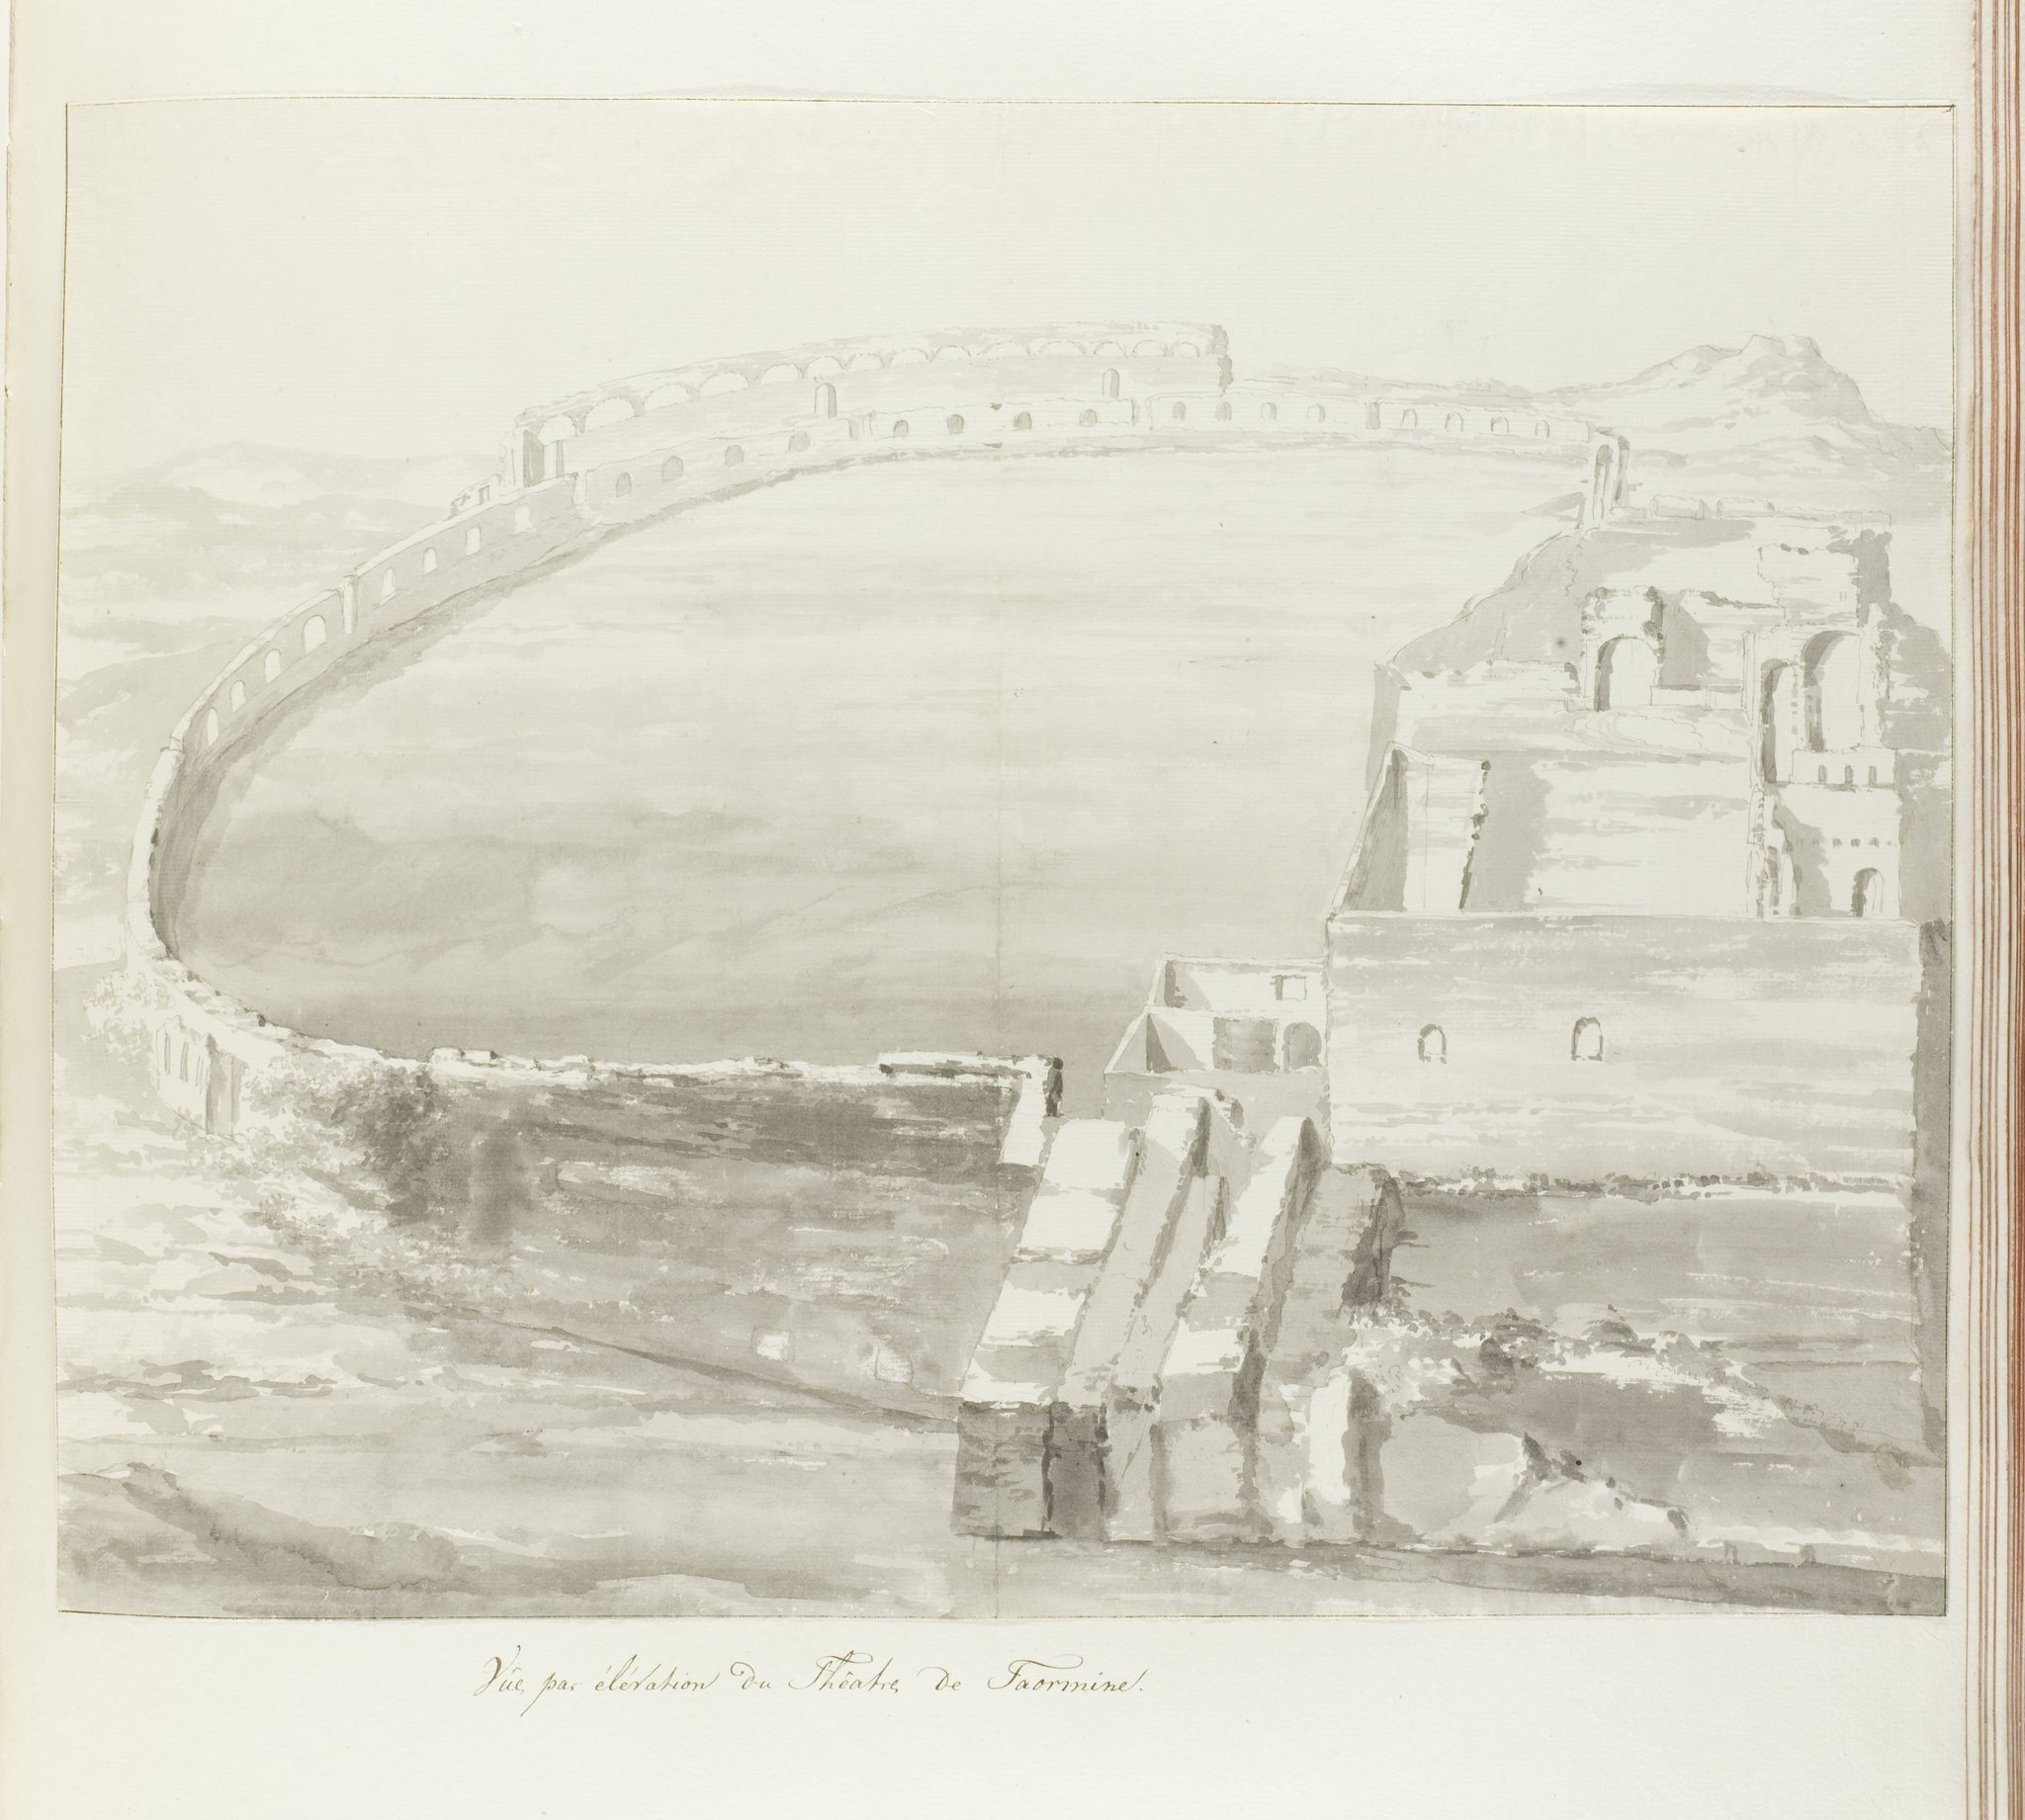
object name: drawing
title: Vue par élévation du Théâtre de Tavormina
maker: louis ducros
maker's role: draughtsman, print maker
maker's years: 1748-1810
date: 1778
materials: chalk, paper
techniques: brush, pen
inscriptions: inscription: ‘No 160 Vue par élévation du Théâtre de Tavormina’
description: Tekening uit het album 'Voyage en Italie, en Sicile et à Malte', 1778.